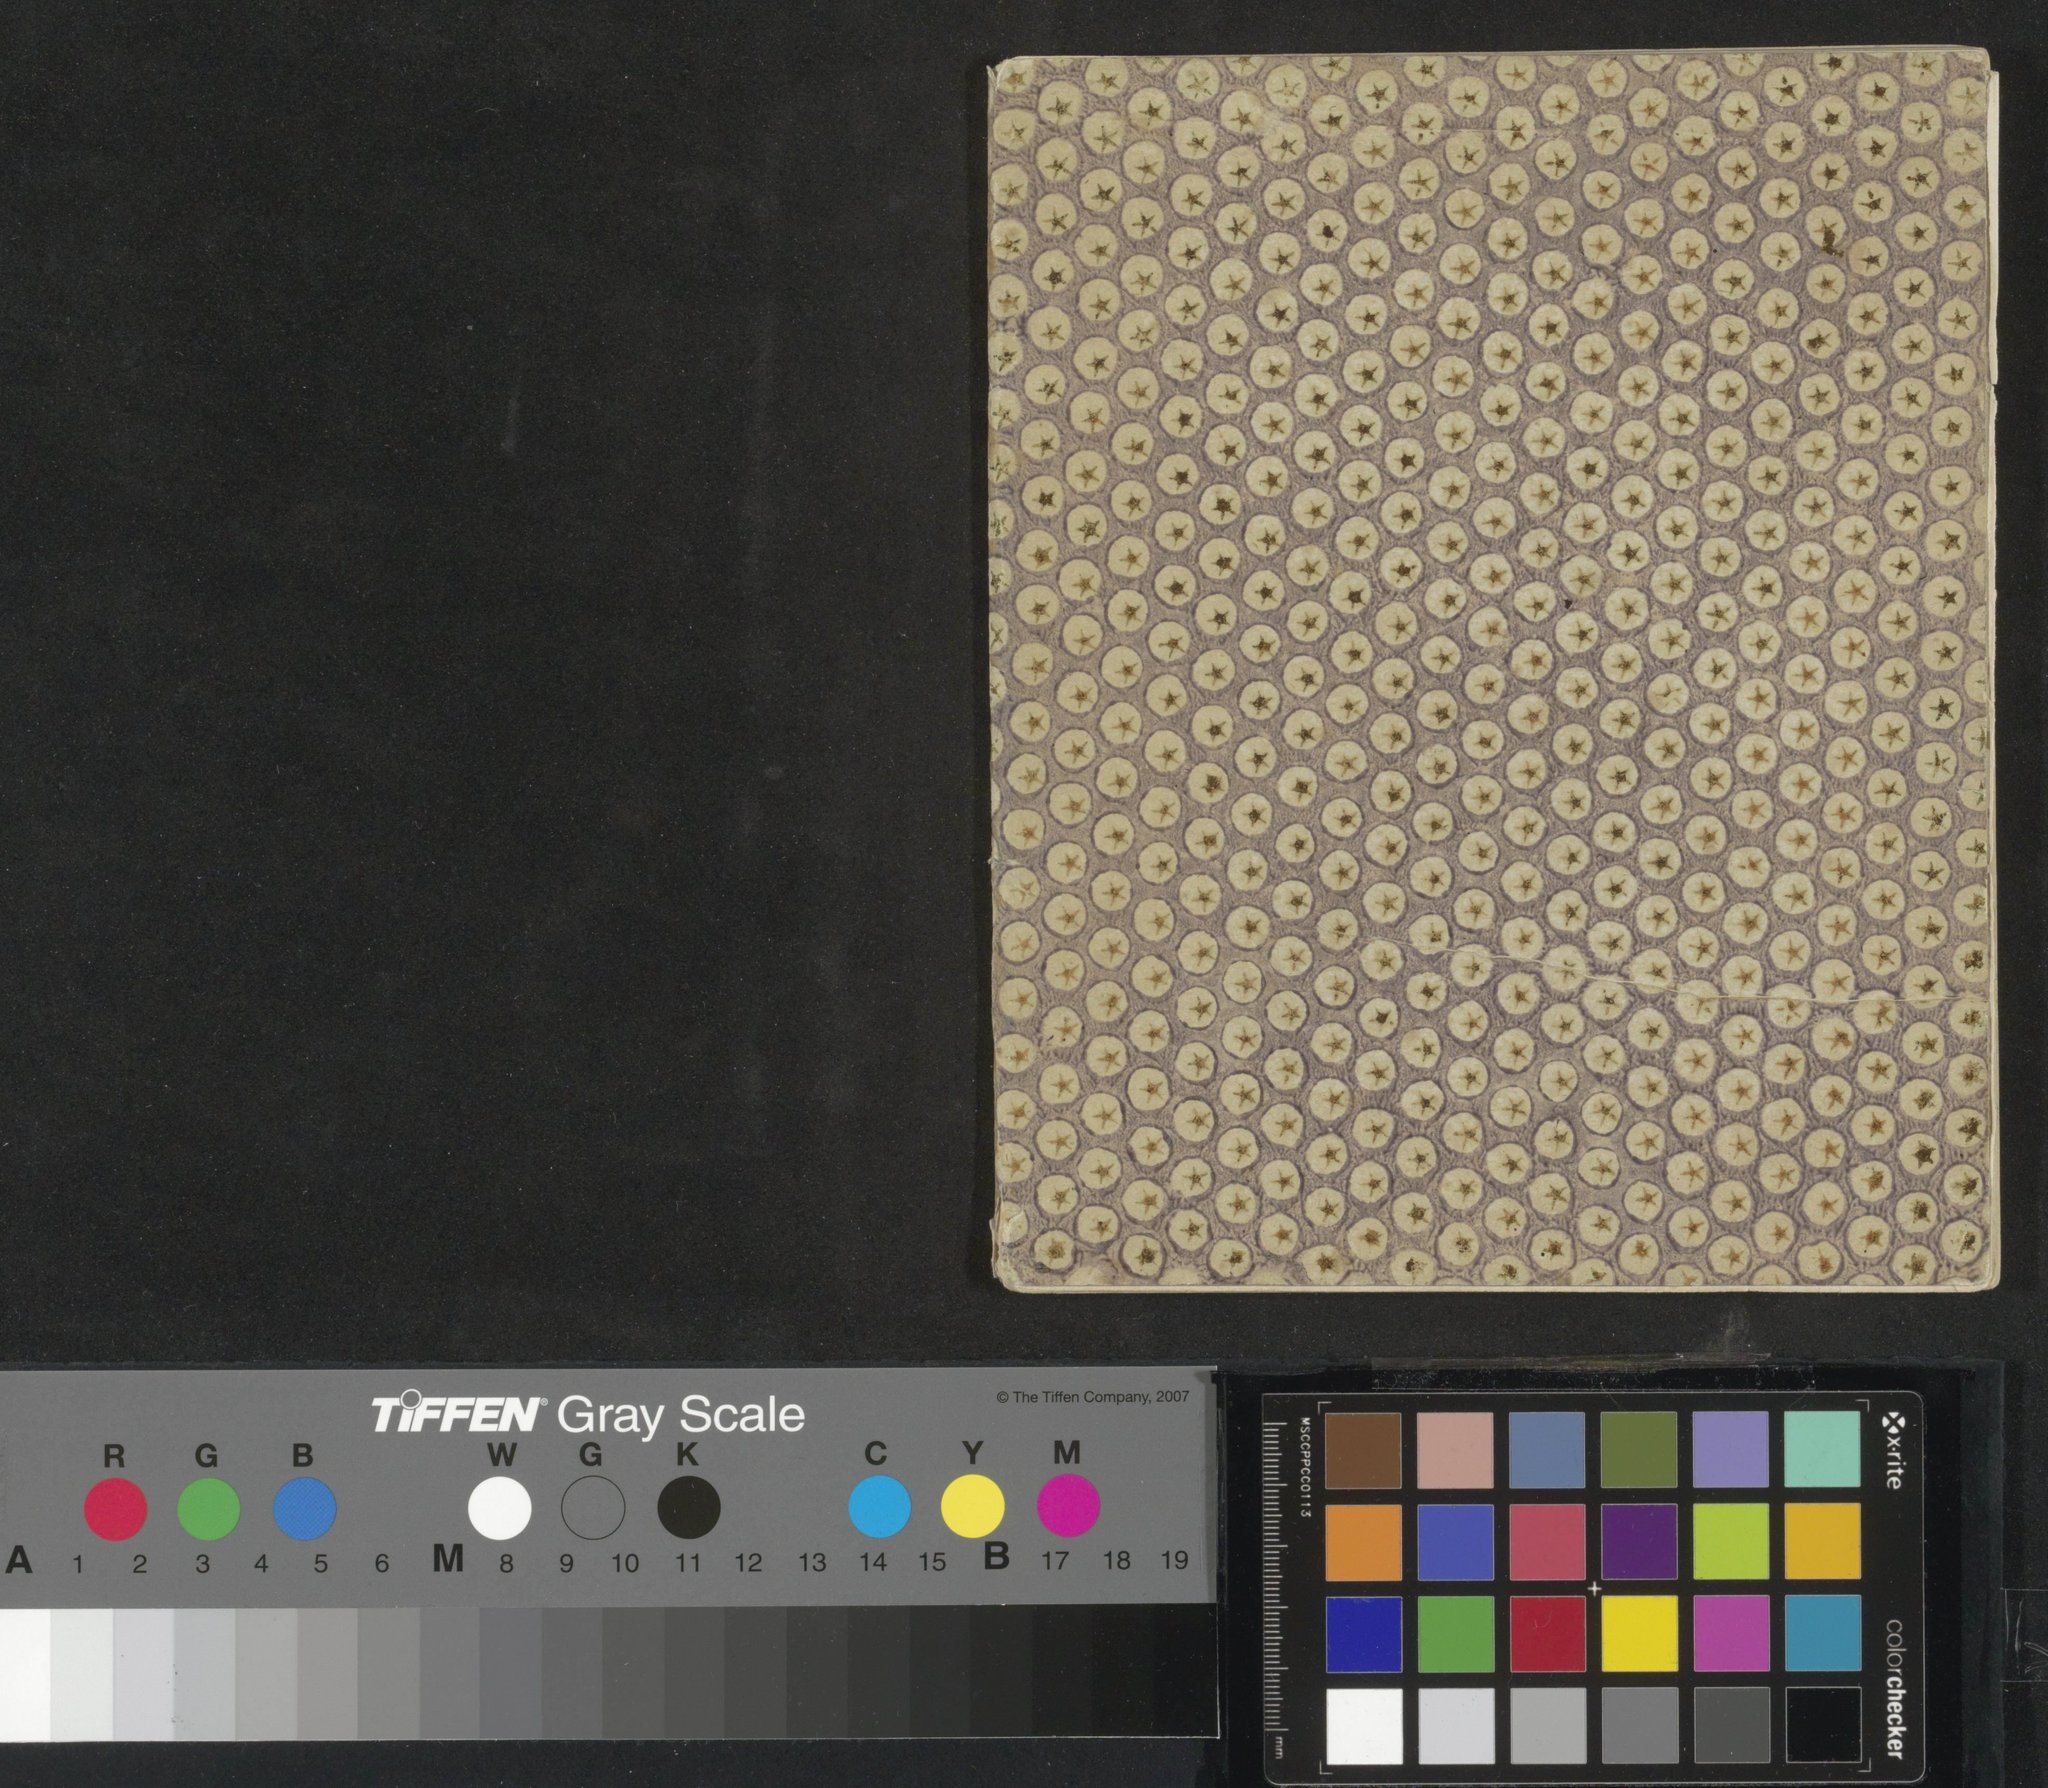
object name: sketchbook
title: Schetsboek met 21 bladen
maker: maria vos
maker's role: draughtsman, painter, print maker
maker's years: 1824-1906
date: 1834-1906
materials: paper, pencil, watercolor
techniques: brush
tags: landscapes, fowl (cock, hen, chicken, etc.), still life of miscellaneous objects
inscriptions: collector's mark: Lugt 2228a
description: De volgende bladen zijn blanco: 1(R), 10(R), 11(R), 13(R), 14(R) t/m 20(R) en 2(V) t/m 15(V).